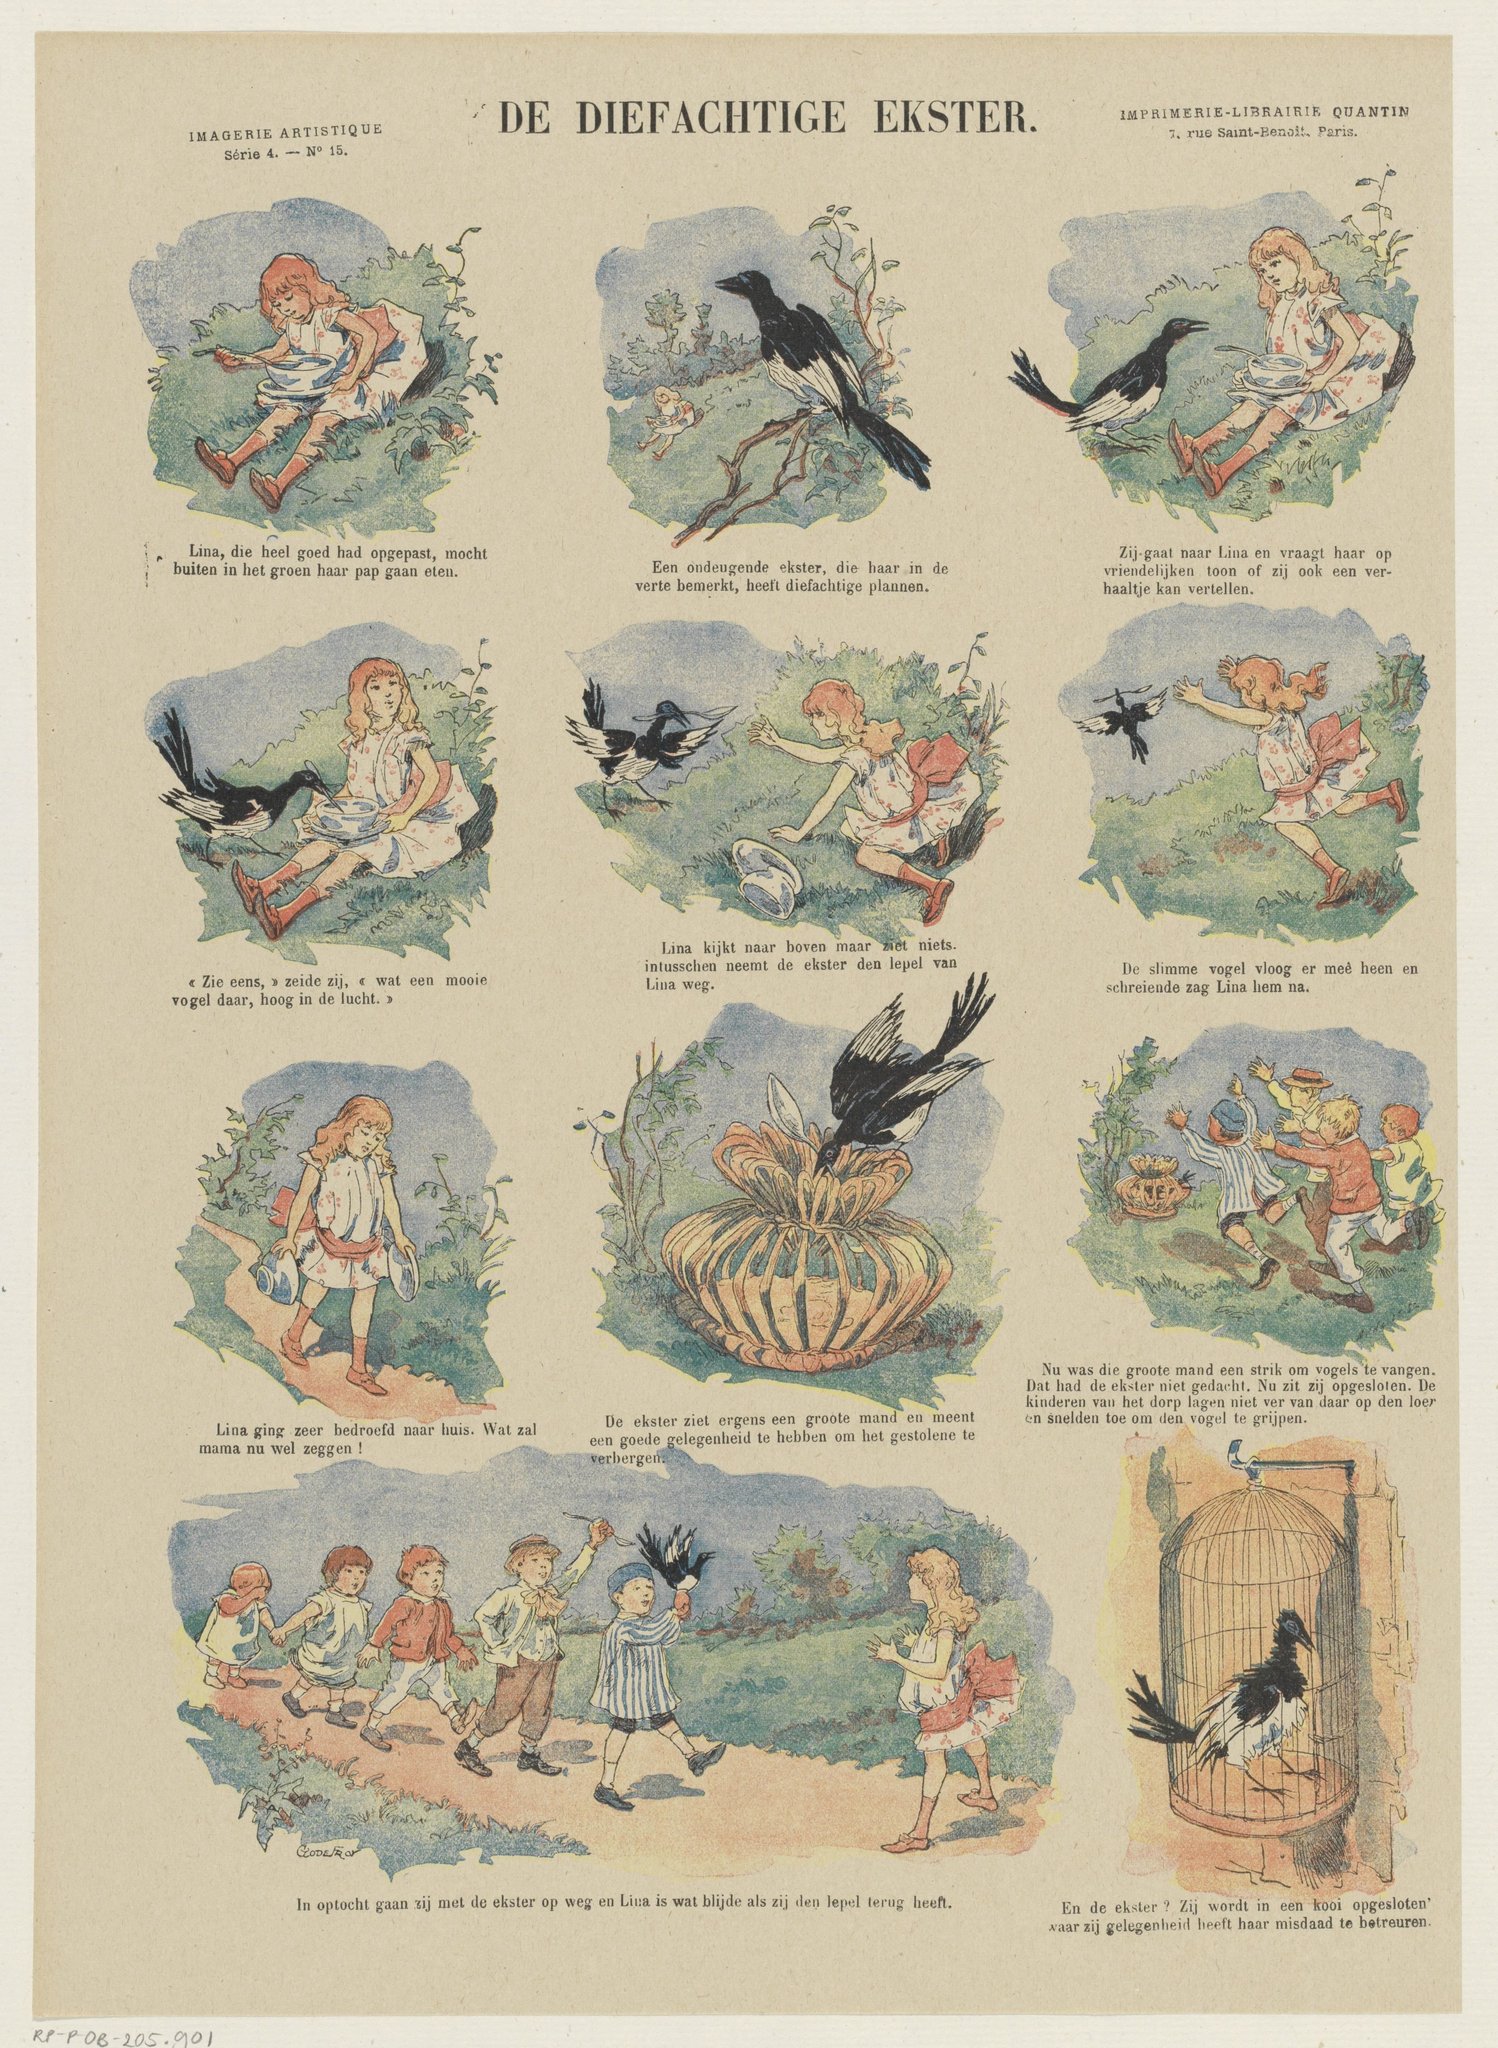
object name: popular print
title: De diefachtige ekster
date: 1876-1890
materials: paper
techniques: lithograph, letterpress printing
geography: paris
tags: theft, tales and fairy tales, song-birds: magpie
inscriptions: collector's mark: Lugt 2760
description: Blad met 11 voorstellingen van een ekster die een lepel van het meisje Lina steelt. Voor straf wordt de ekster opgesloten in een kooi. Onder elke voorstelling een onderschrift. Genummerd linksboven: Série 4. - No. 15.